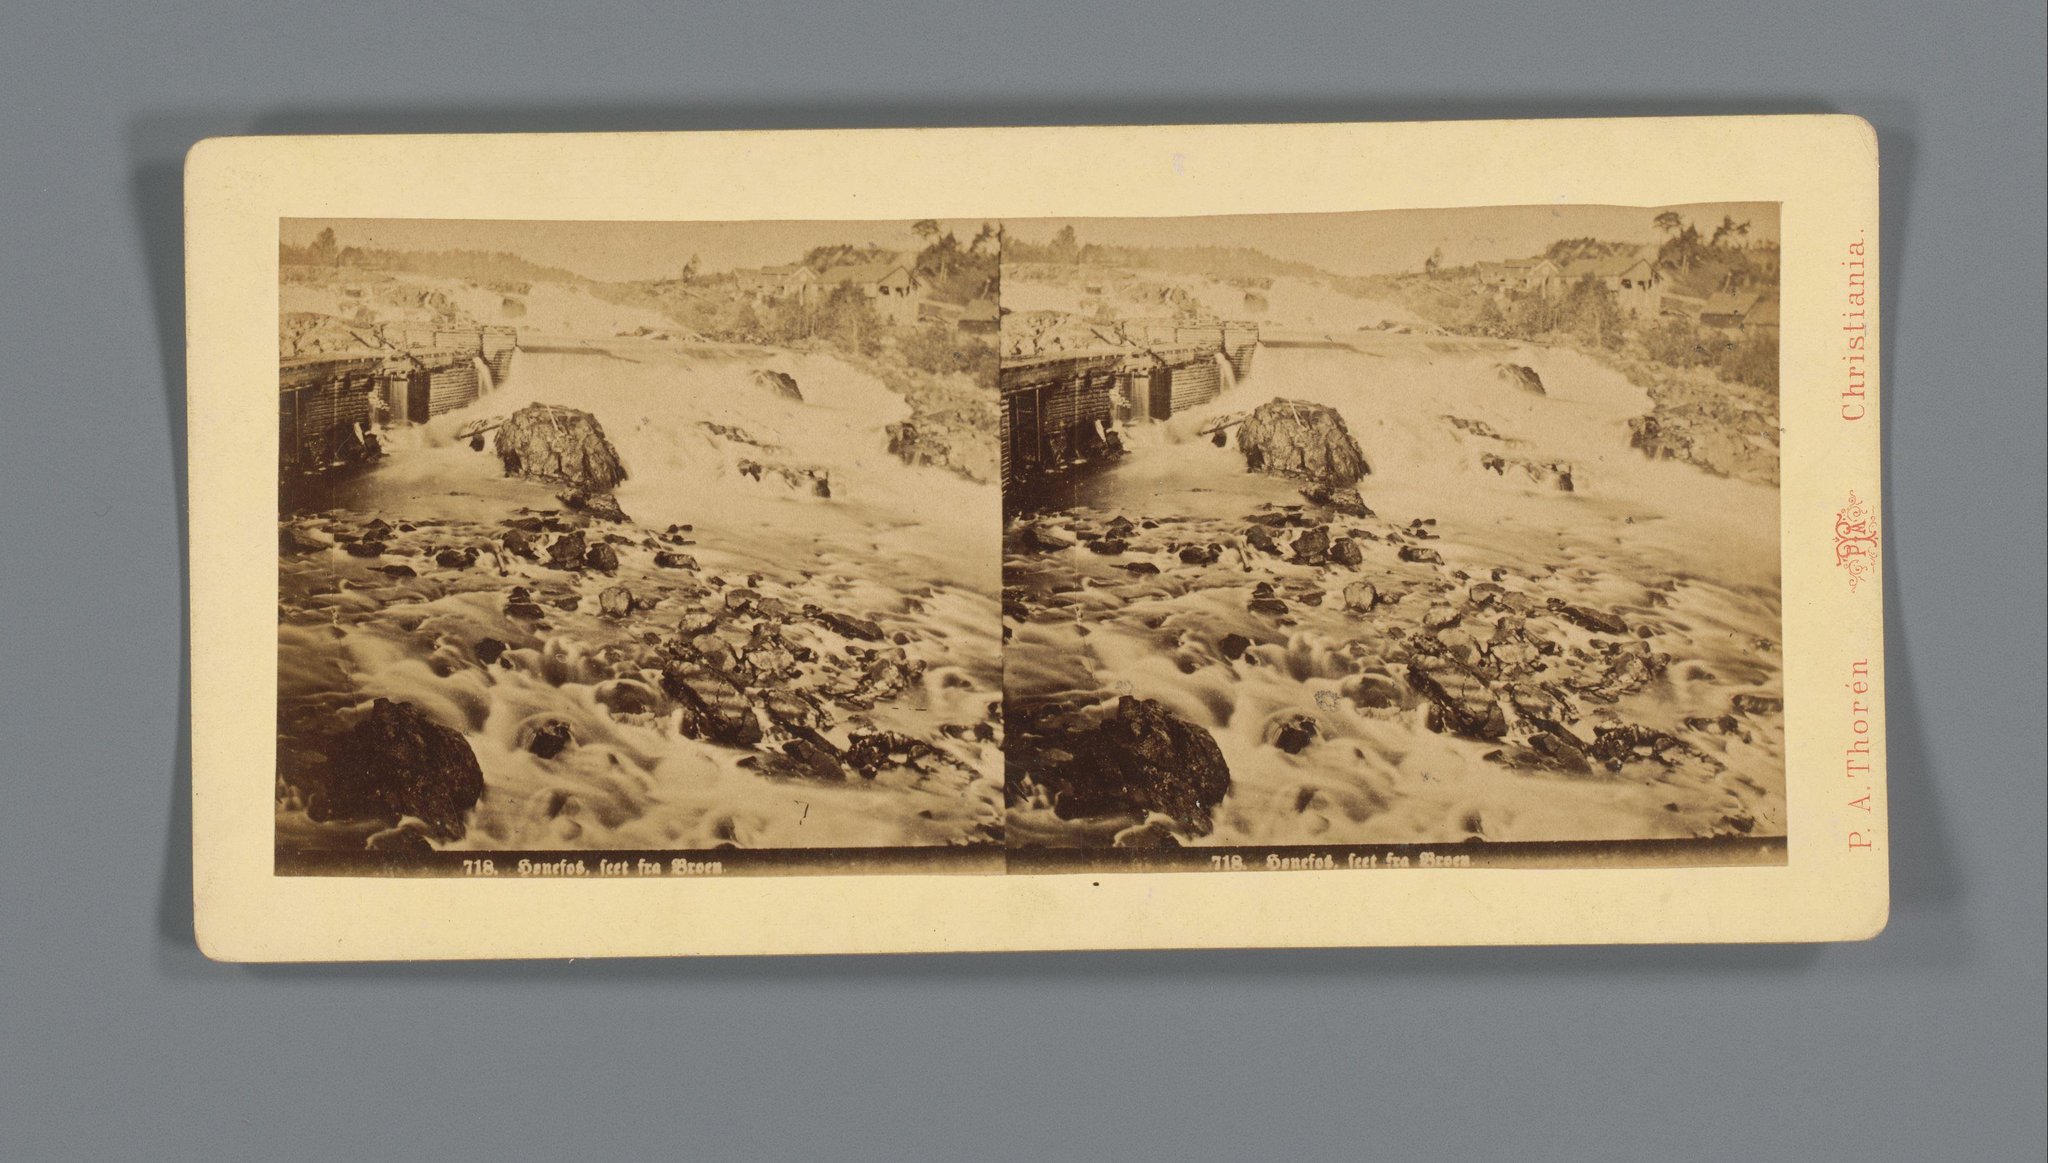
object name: stereograph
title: Honefos, seet fra Broen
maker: per adolf thorén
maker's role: fotograaf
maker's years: 1830-1909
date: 1865-1870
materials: cardboard, paper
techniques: albumen print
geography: hønefoss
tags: river, waterfall, bridge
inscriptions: inscription: ‘Prijsbetönnet/ ved/ Udstillingen/ i/ Stockholm 1866.’